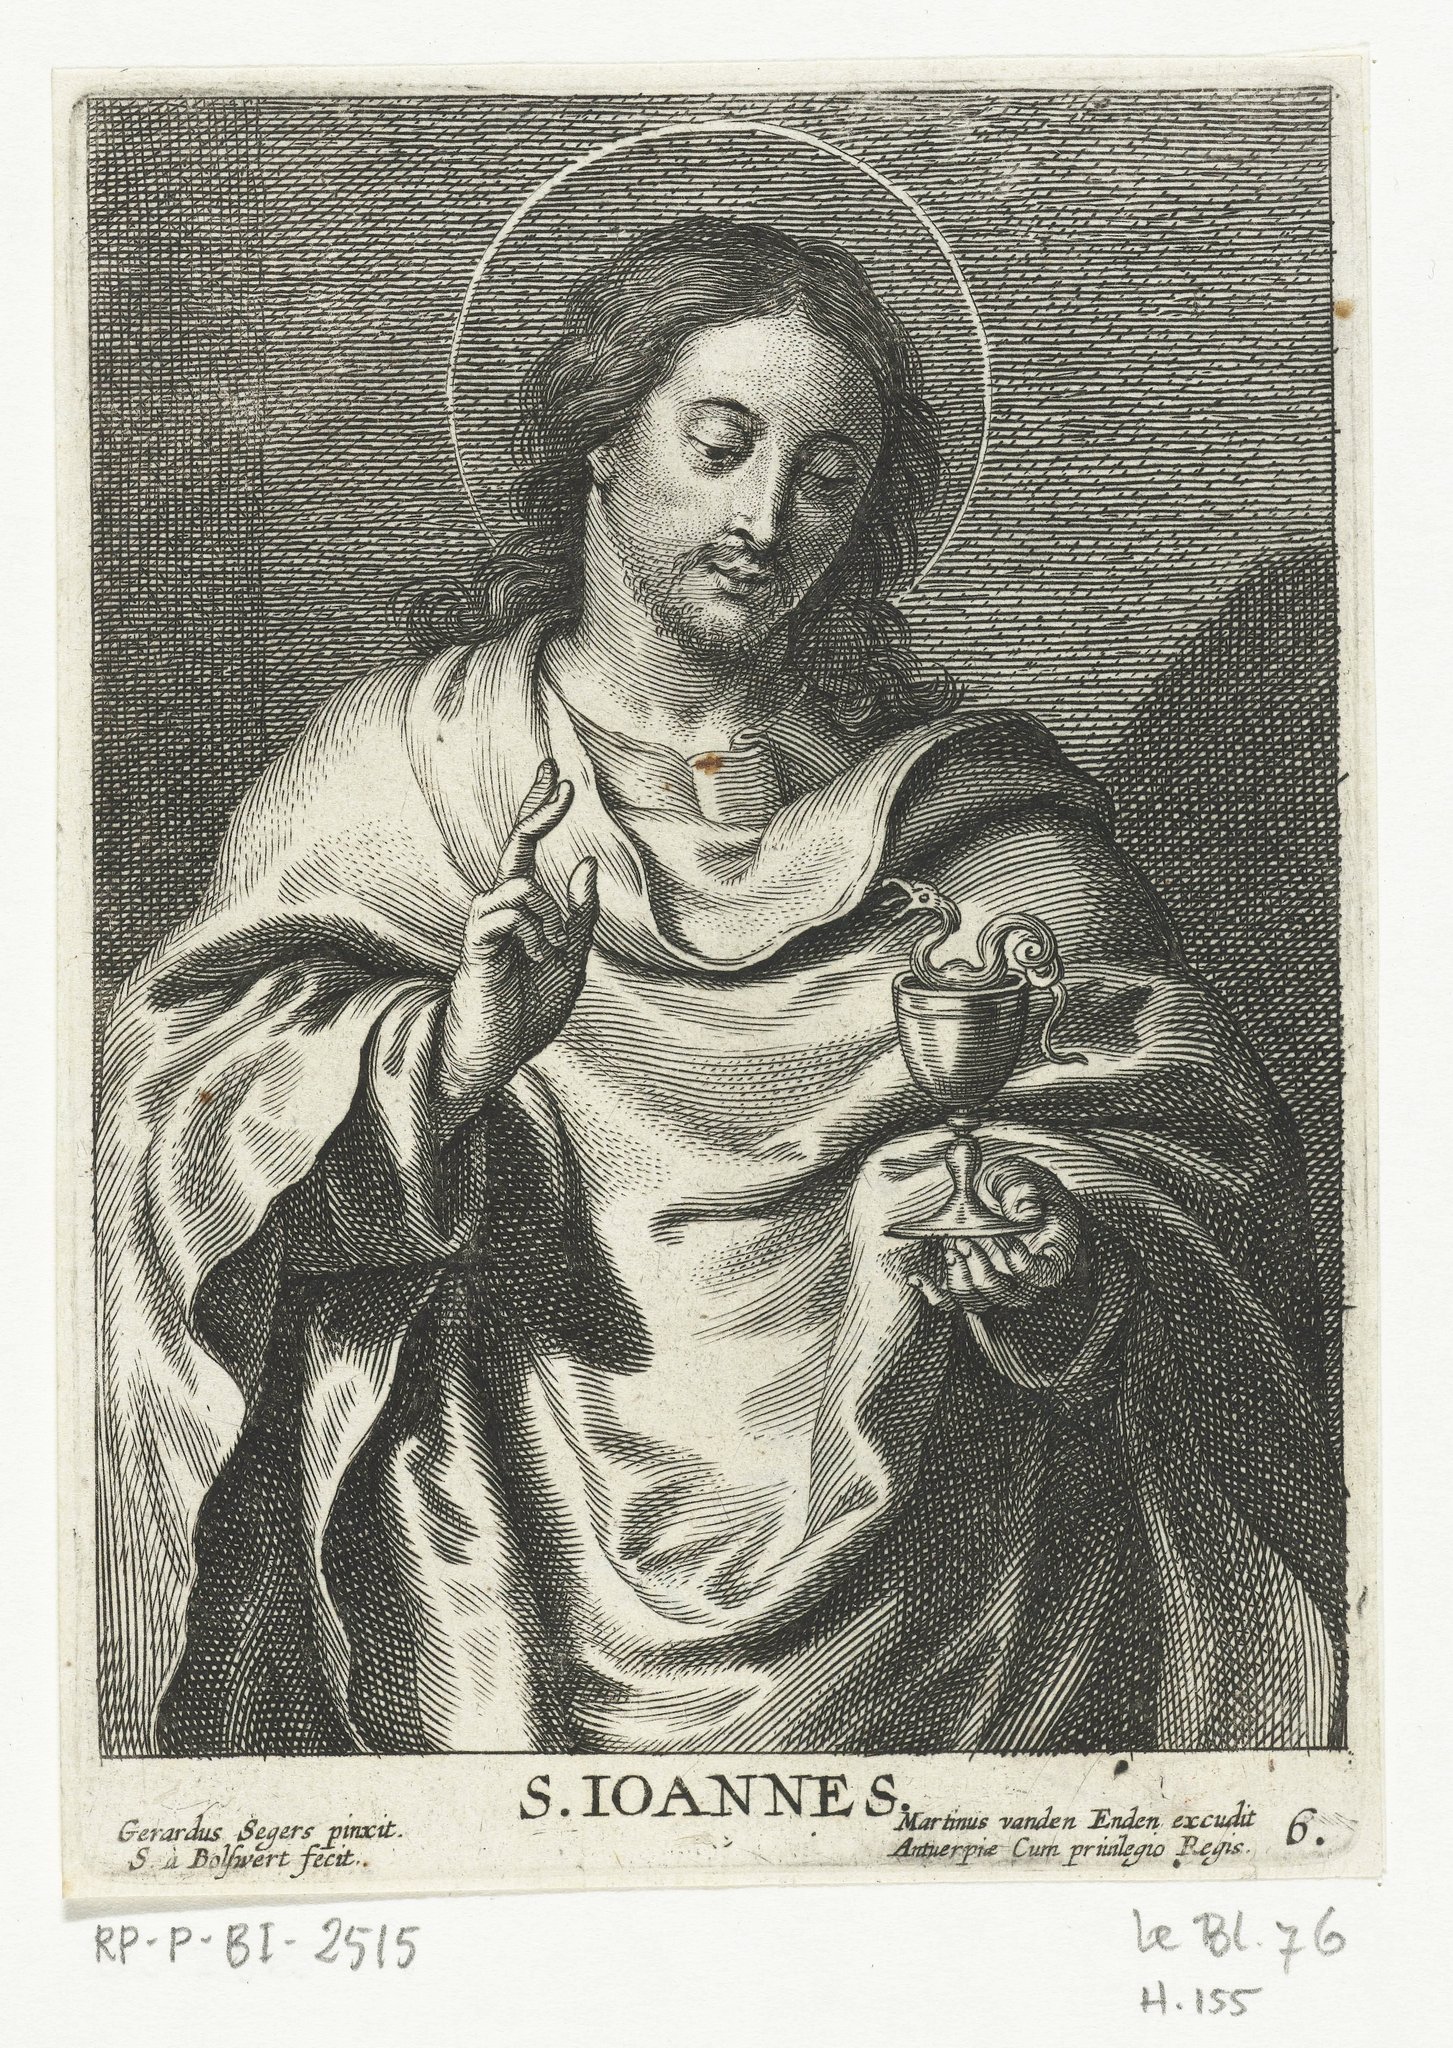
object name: print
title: S. Ioannes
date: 1596-1659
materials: paper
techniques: engraving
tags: the apostle john the evangelist; possible attributes: book, cauldron, chalice with snake, eagle, palm, scroll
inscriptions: collector's mark: Lugt 240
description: Prent uit serie met veertien prenten met Christus, Paulus en twaalf apostelen naar ontwerp van Gerard Seghers.